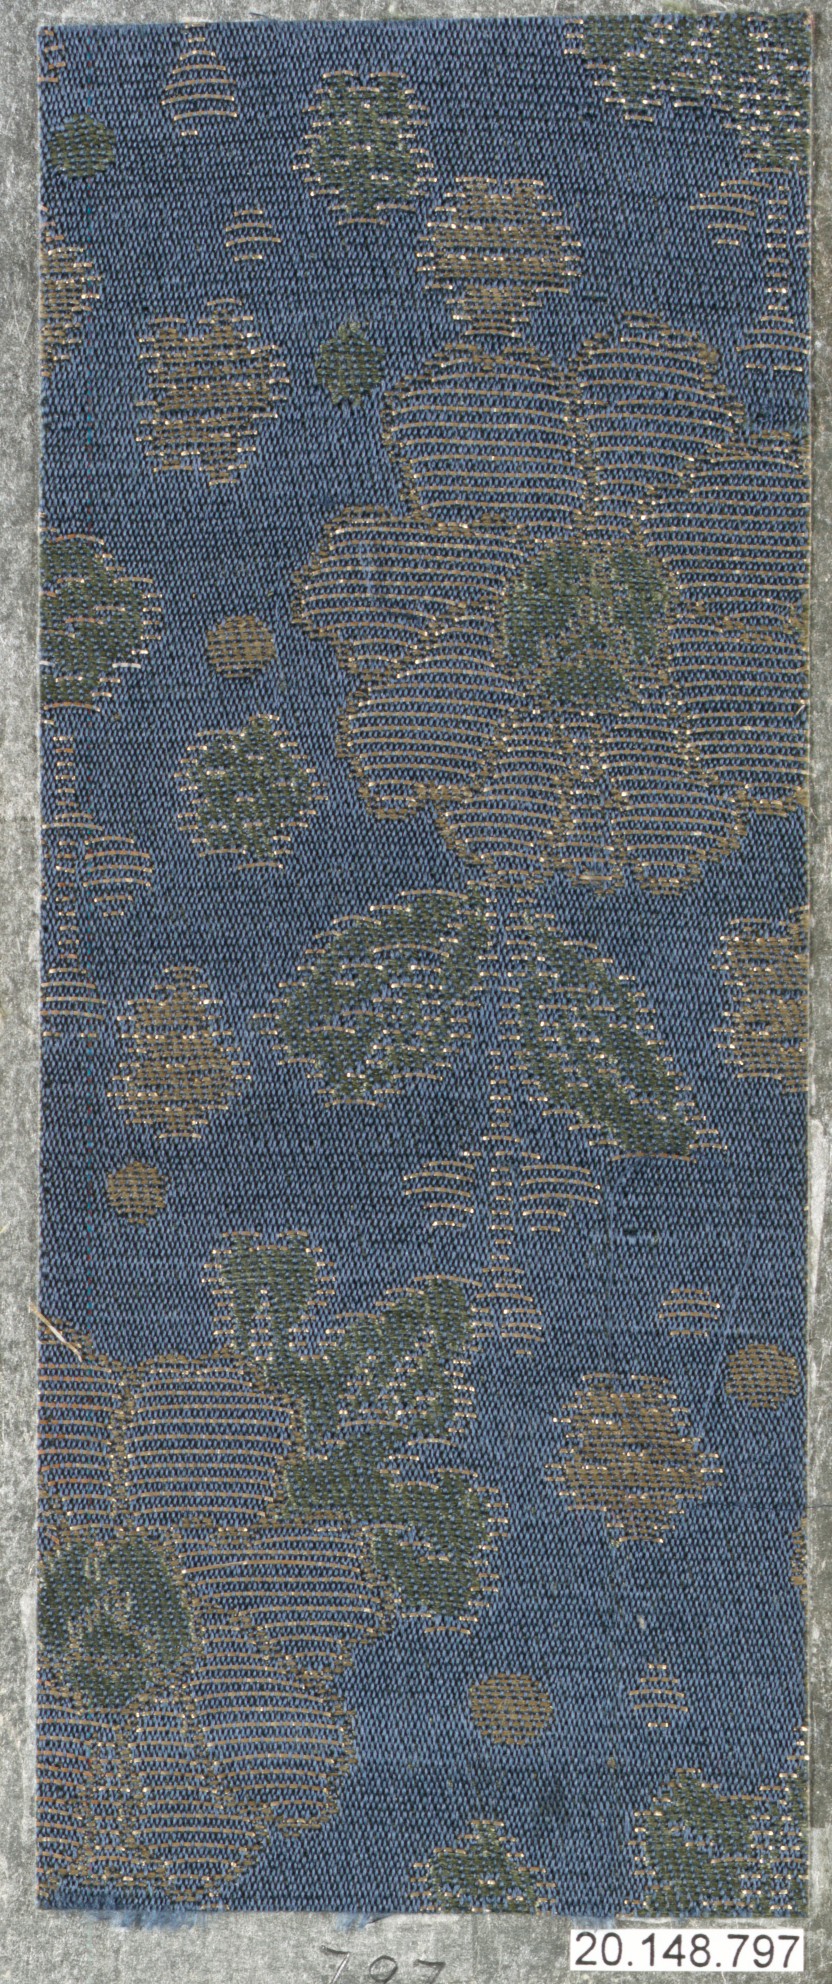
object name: piece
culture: japanese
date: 1701-1800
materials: silk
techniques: compound weave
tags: flowers,leaves